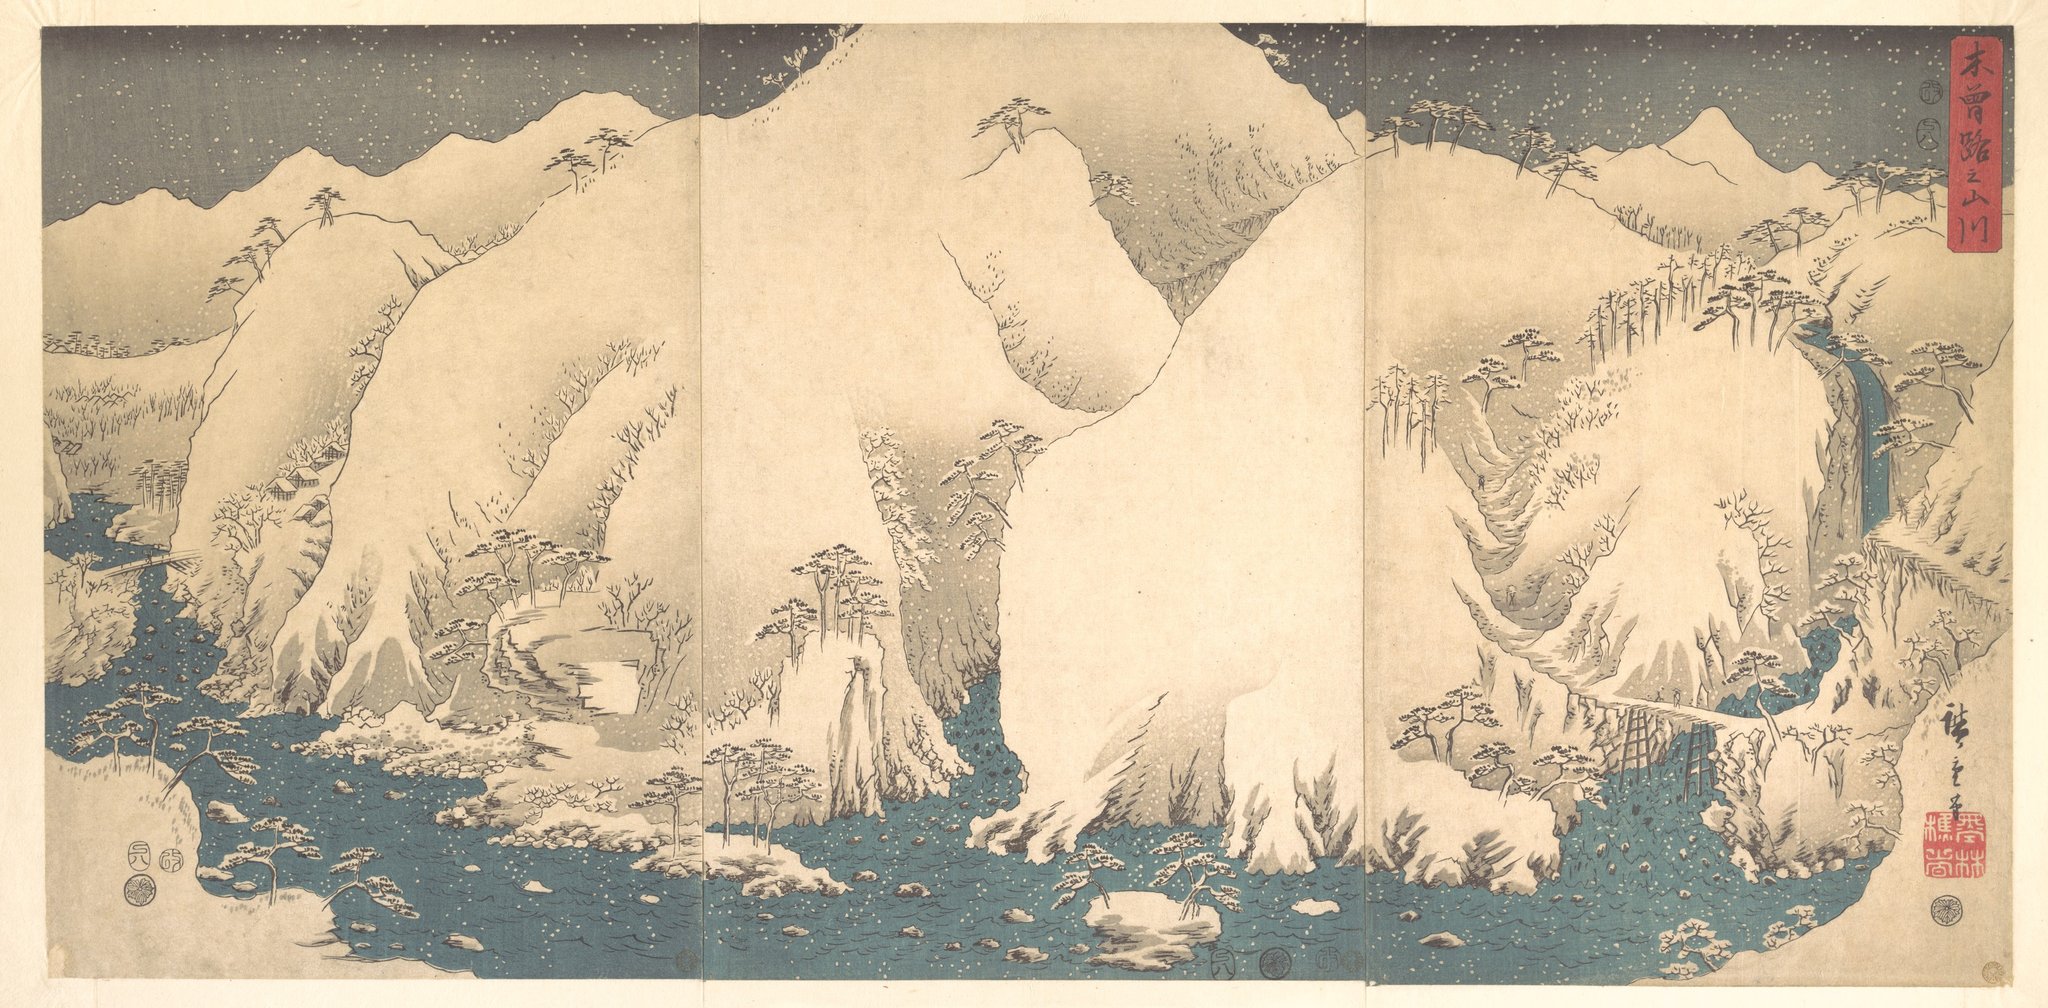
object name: woodblock print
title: The Kiso Mountains in Snow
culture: japanese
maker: utagawa hiroshige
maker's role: artist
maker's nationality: japanese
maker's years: 1797-1858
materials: ink, paper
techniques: woodblock print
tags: mountains,snow